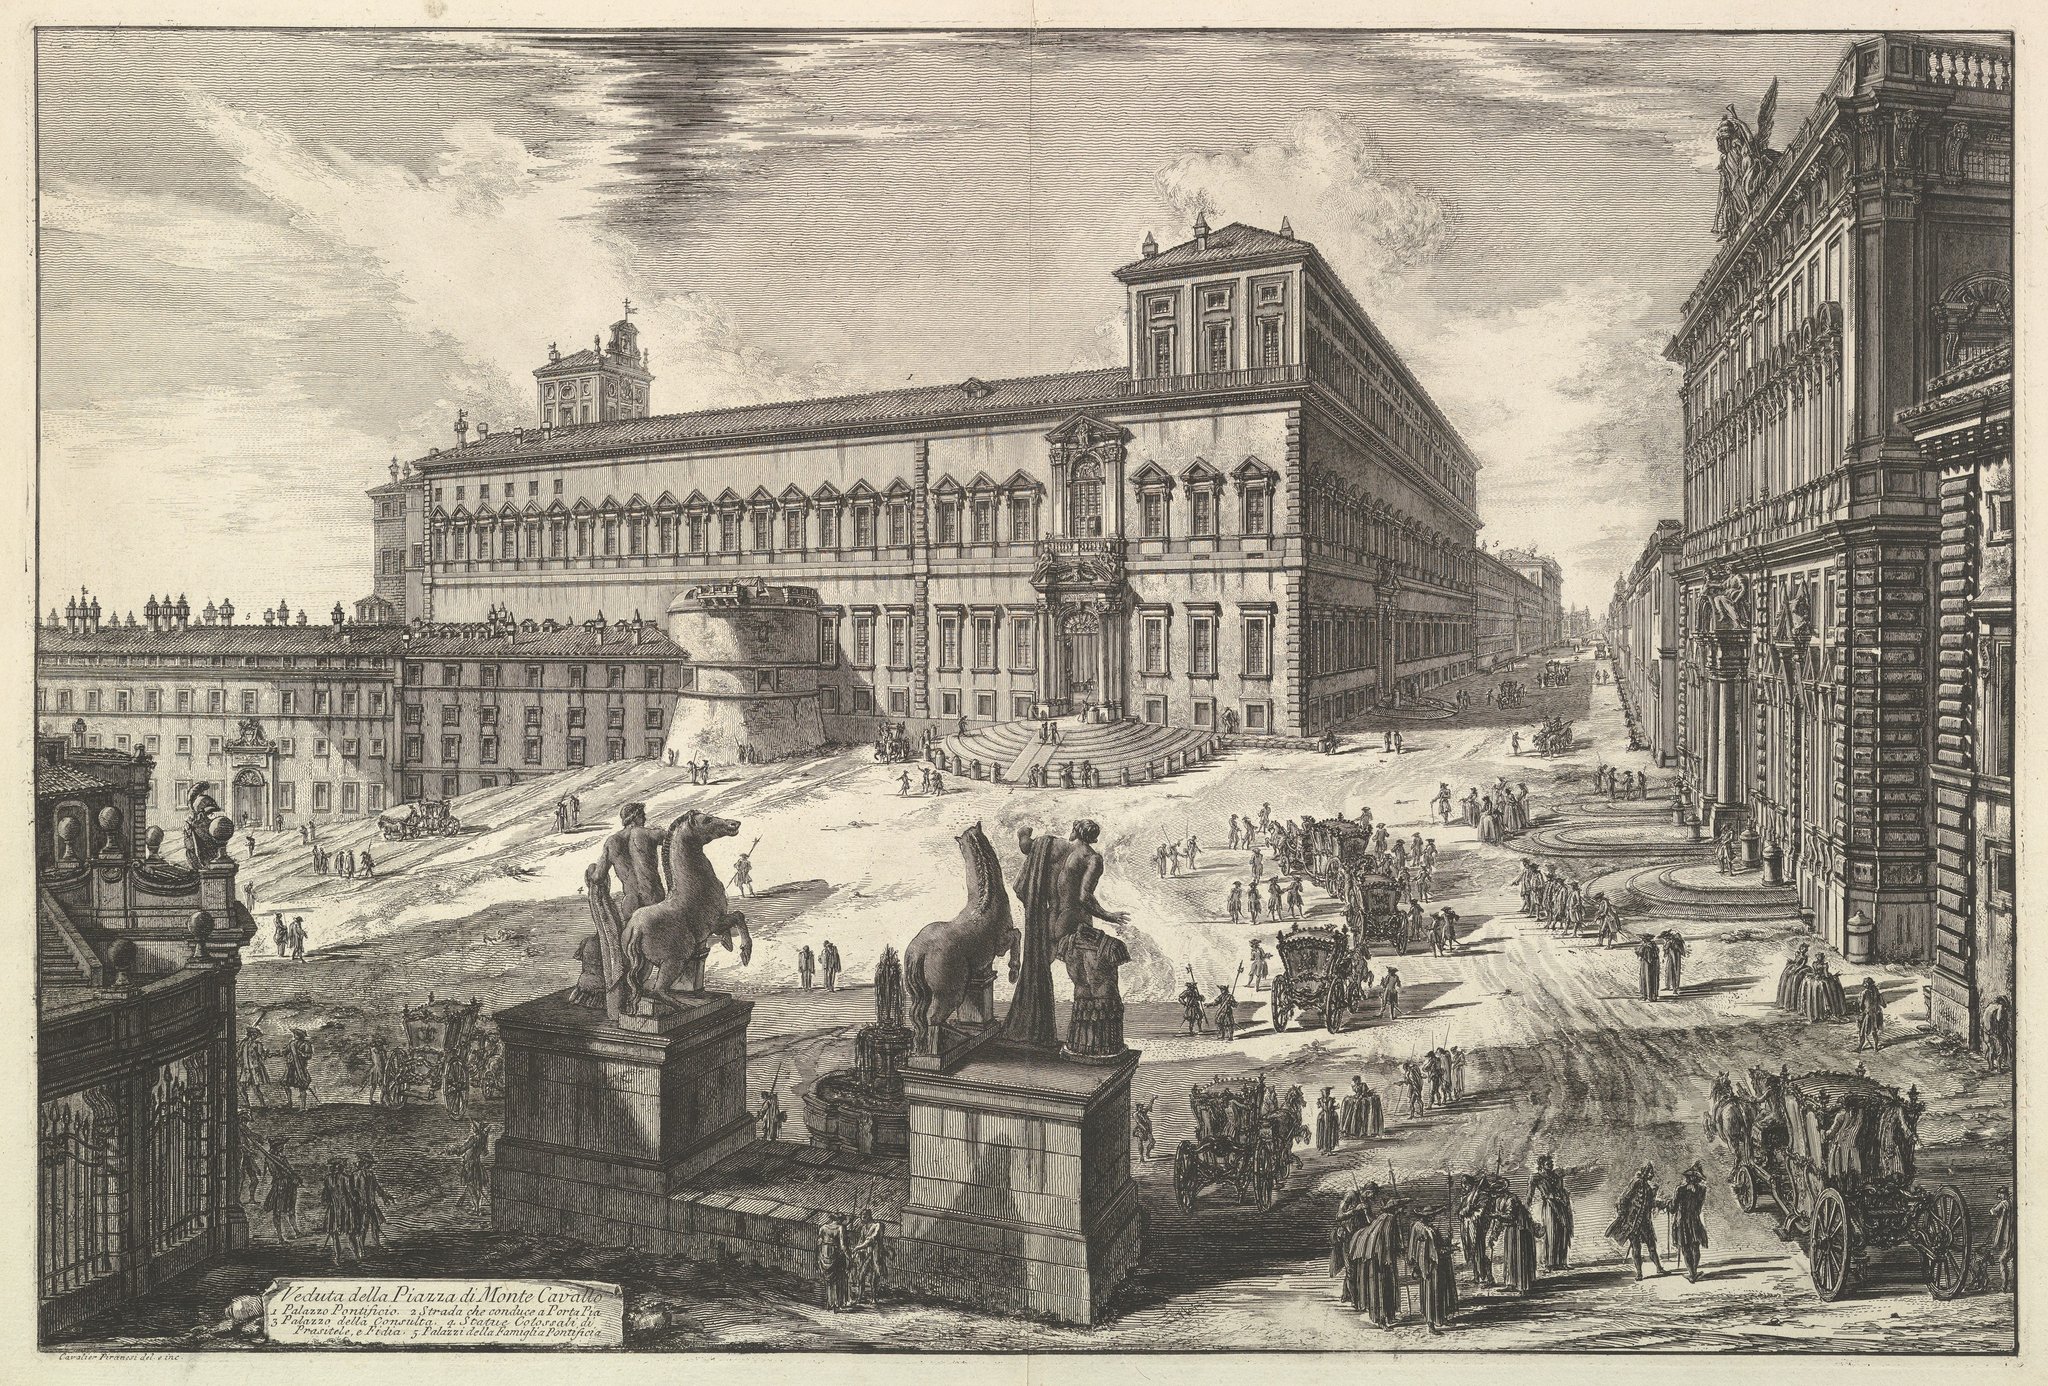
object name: print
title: View of the Piazza di monte Cavallo, from Vedute di Roma (Roman Views)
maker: giovanni battista piranesi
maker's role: artist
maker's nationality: italian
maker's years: 1720-1778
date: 1773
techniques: etching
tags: human figures,buildings,horses,carriages,rome